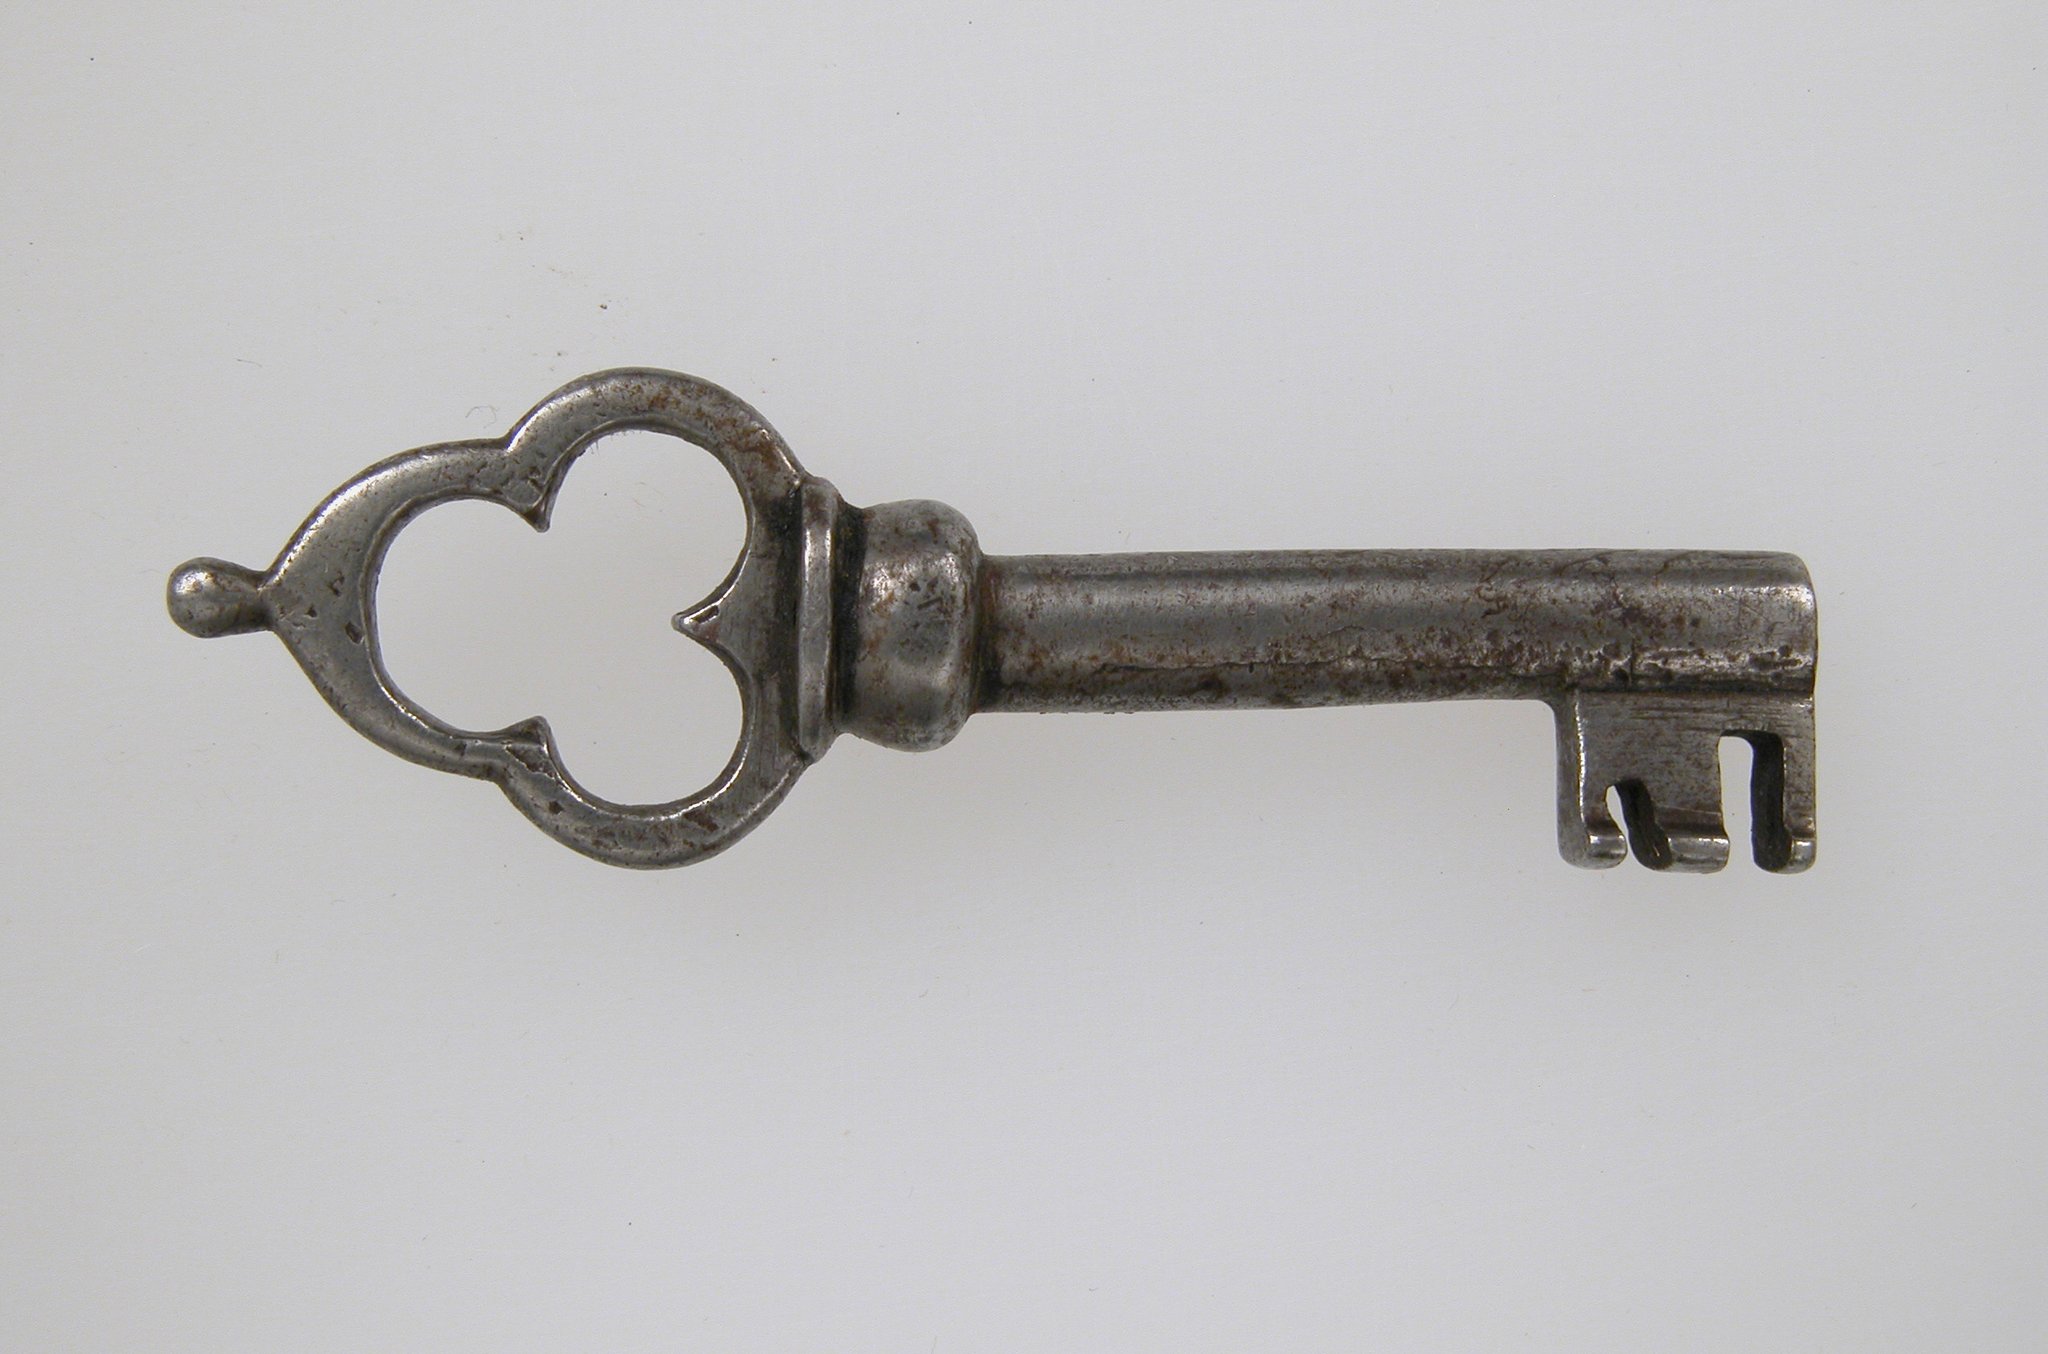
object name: key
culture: german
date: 1401-1500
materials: iron